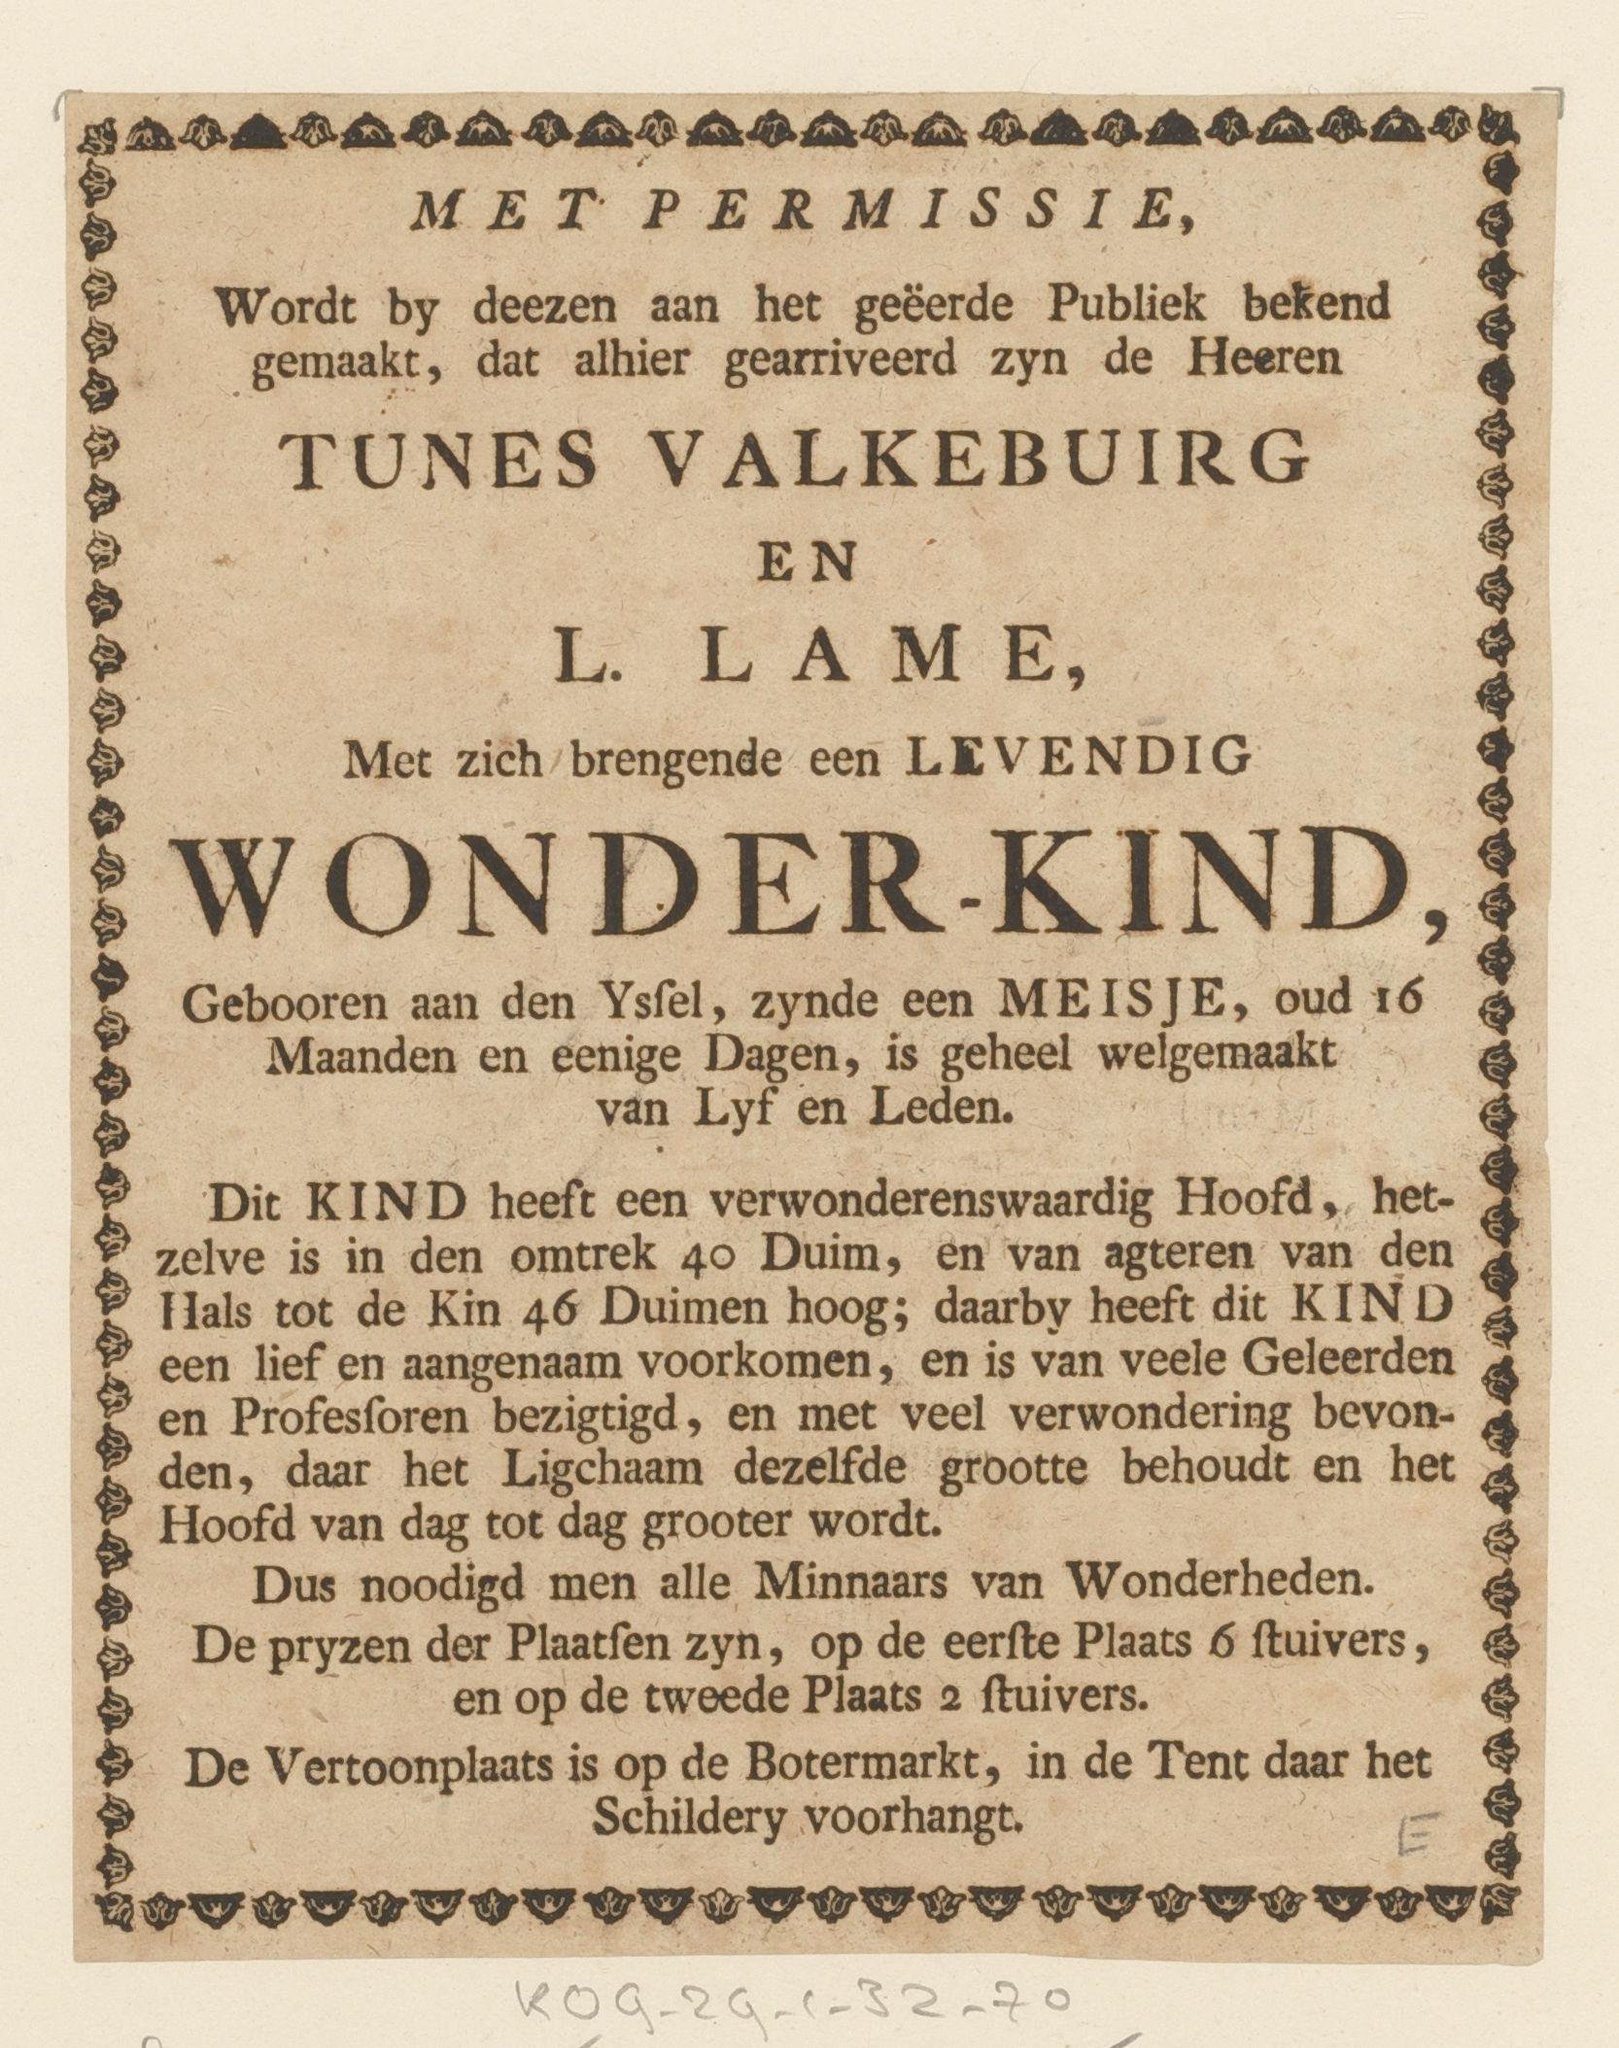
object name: reclamebiljet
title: De heeren Tunes Valkenbuirg en L. Lame, met zich brengende een levendig Wonder-kind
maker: Anonymous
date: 1806-1815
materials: paper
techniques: letterpress printing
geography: netherlands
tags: female infant, deformations of the head - aa - female human figure, pleasure fair and circus, human monstrosities ~ freak show, amsterdam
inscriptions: collector's mark: Lugt 1641, collector's mark